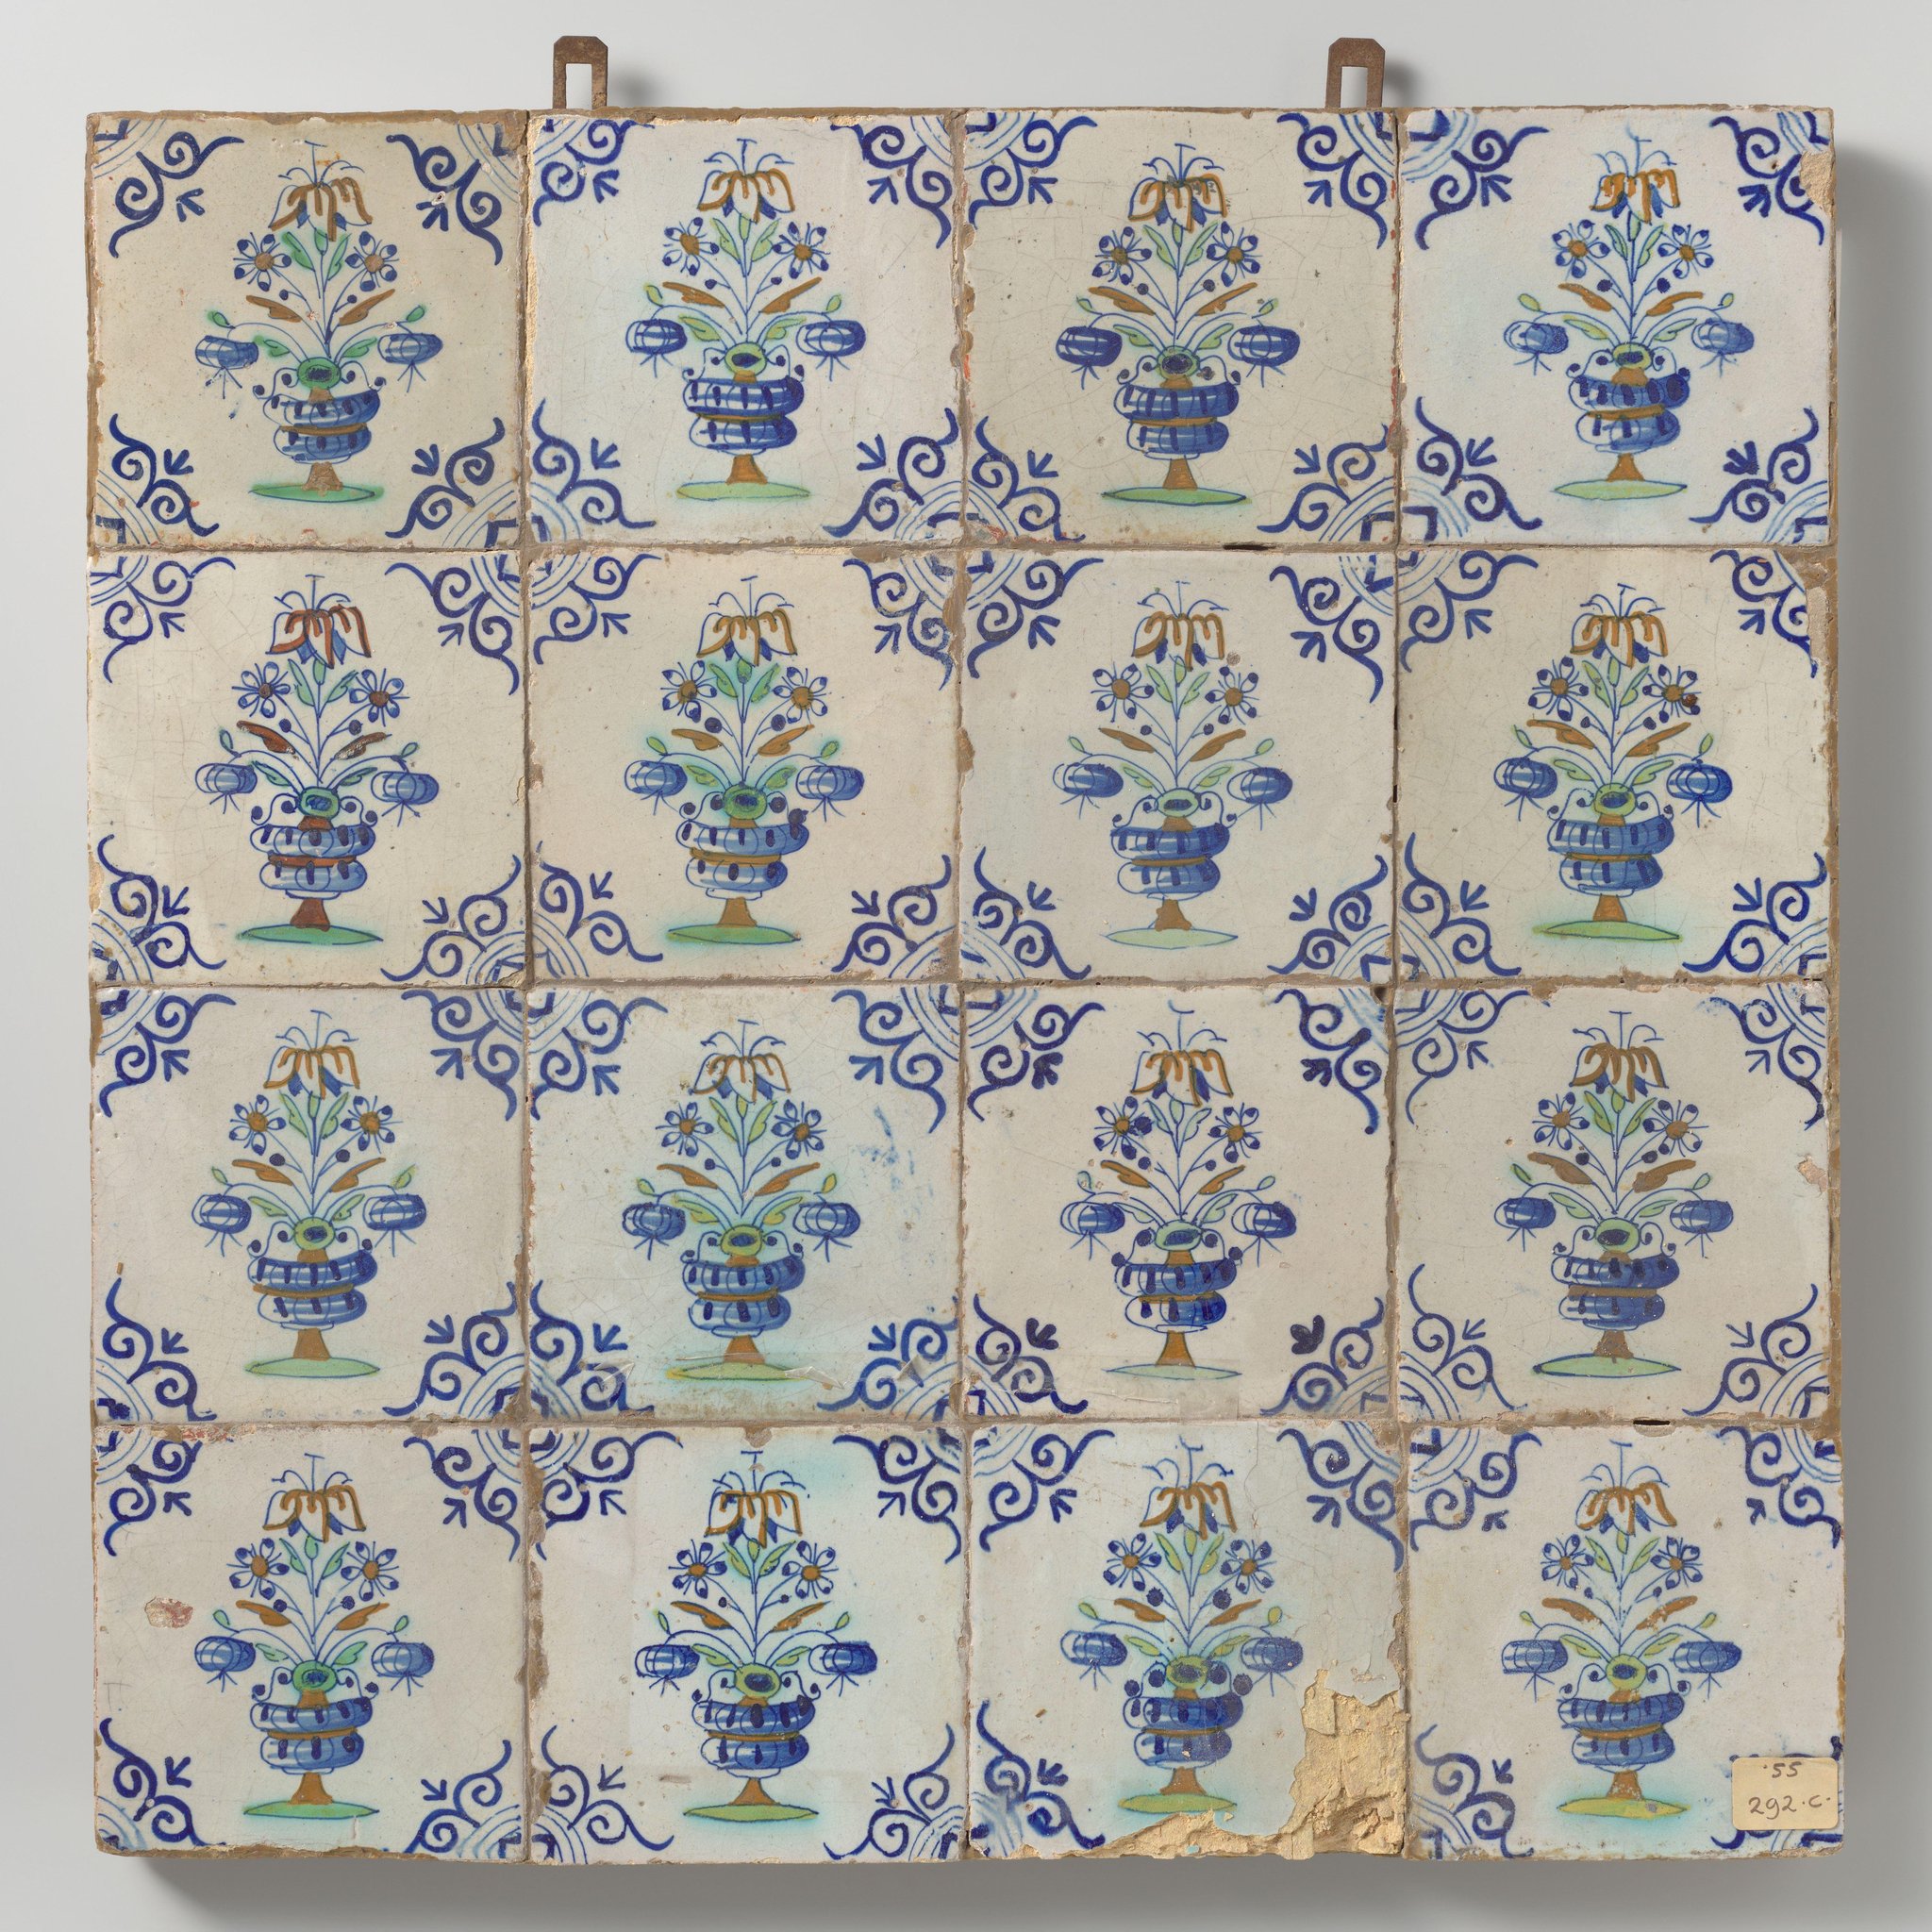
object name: tile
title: Veld van zestien tegels met bloempotten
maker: Anonymous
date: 1625-1670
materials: earthenware, glaze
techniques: maiolica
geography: netherlands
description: Veld van zestien tegels (4 x 4) met een veelkleurige (blauw, groen en oranje) bloempot met in de hoeken, een ossenkop.